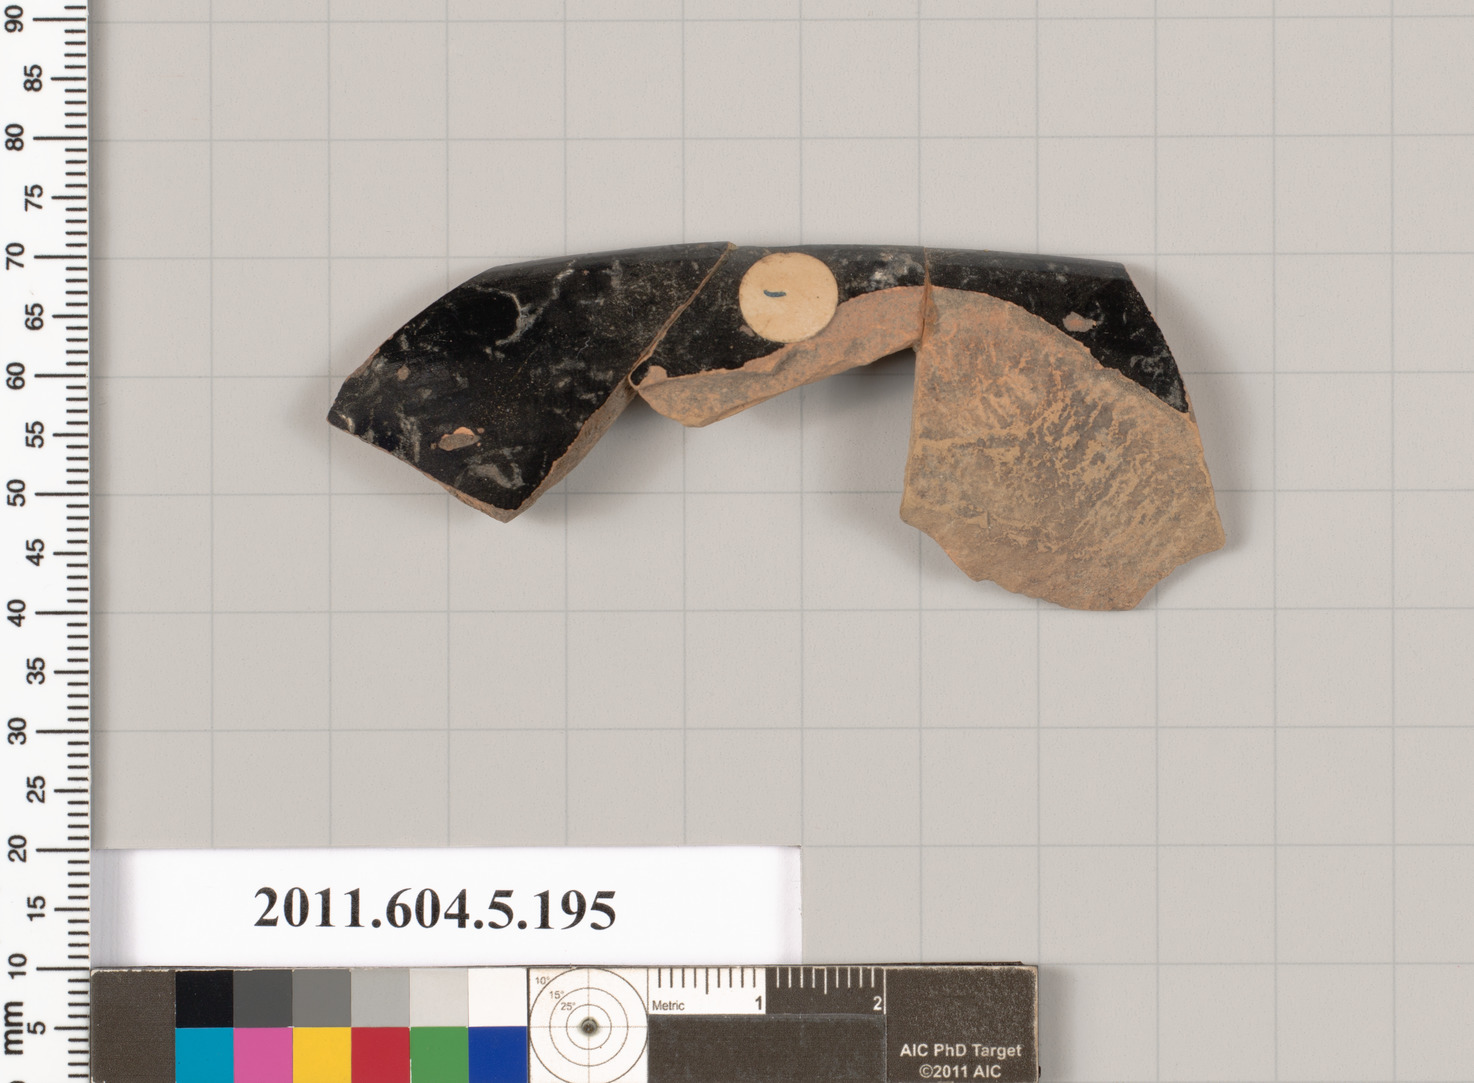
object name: kylix fragment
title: Terracotta rim fragment of a kylix (drinking cup)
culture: greek, attic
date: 600-401 BCE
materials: terracotta